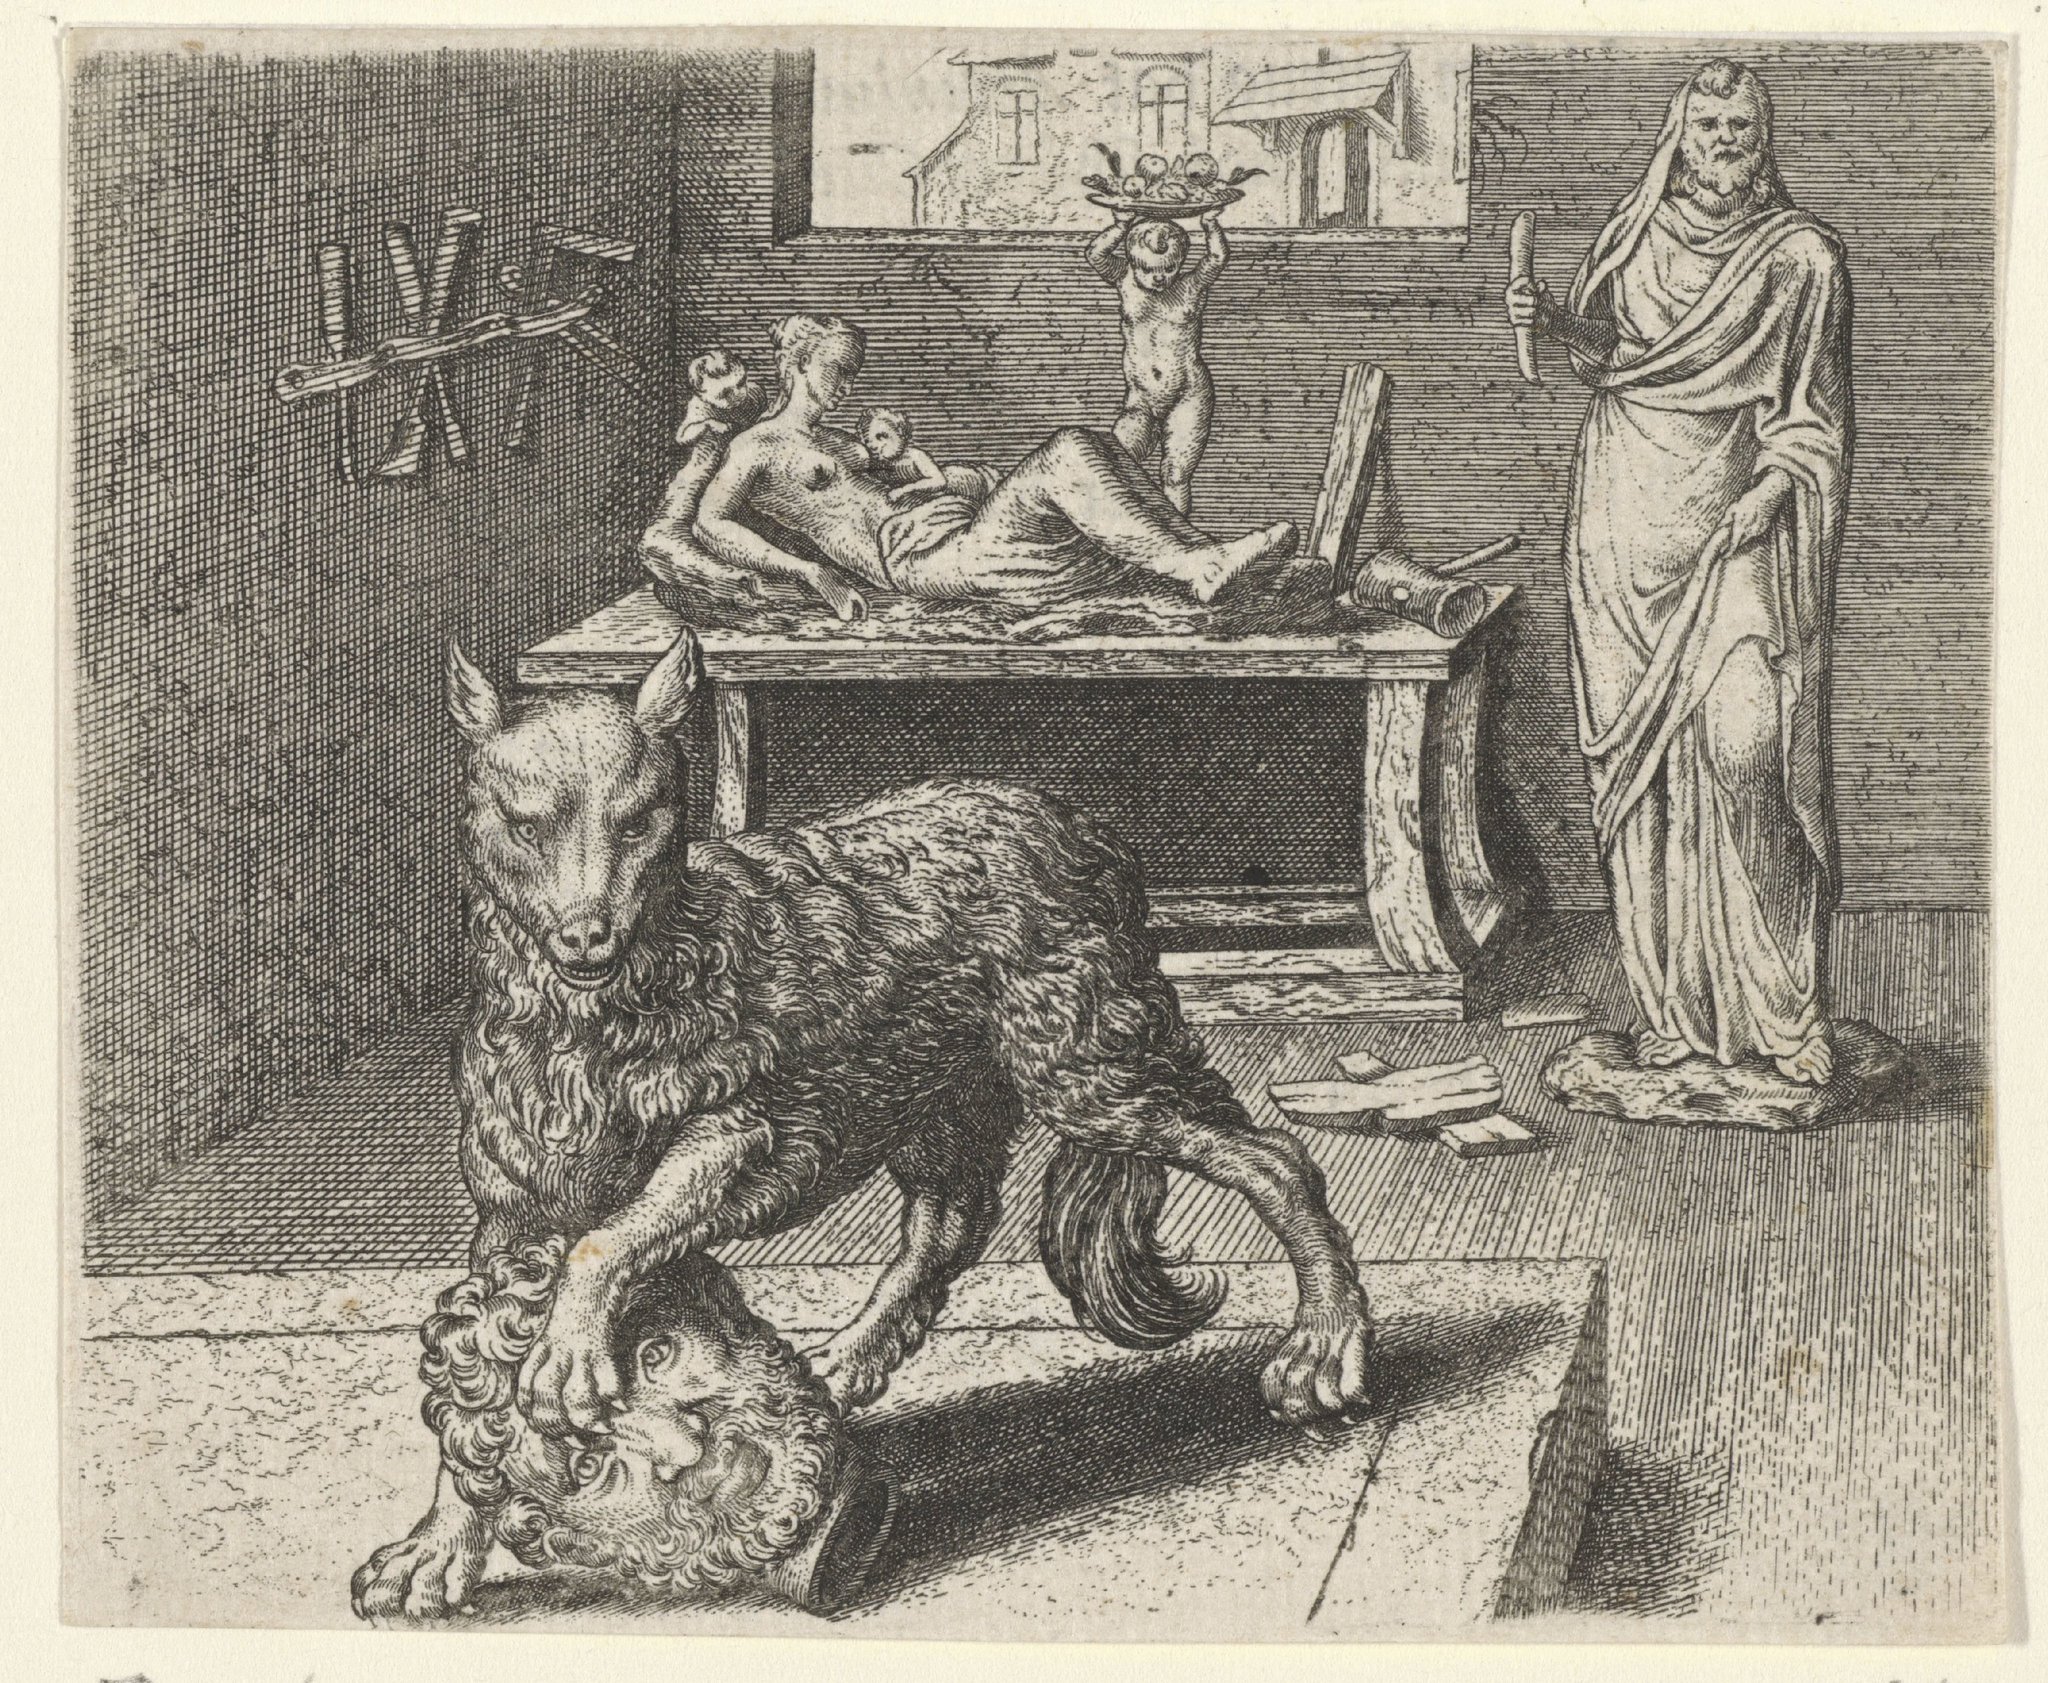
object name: book illustration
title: Fabel van de wolf en het standbeeld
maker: aegidius sadeler (ii)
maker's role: draughtsman, print maker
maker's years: 1568-1629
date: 1608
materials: paper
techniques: engraving, etching, letterpress printing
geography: prague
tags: fables, sculpture, beasts of prey, predatory animals: wolf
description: Een wolf met in zijn poten een gebeeldhouwd hoofd van een man. Op de achtergrond andere beelden. De fabel beschrijft hoe een wolf het atelier van een beeldhouwer ontdekt en de beelden bewondert en ermee speelt. De wolf merkt al snel dat er geen leven in de beelden zit. De moraal van het verhaal leert dat mensen er vaak mooi uit kunnen zien, maar zonder wijsheid van binnen leeg zijn.